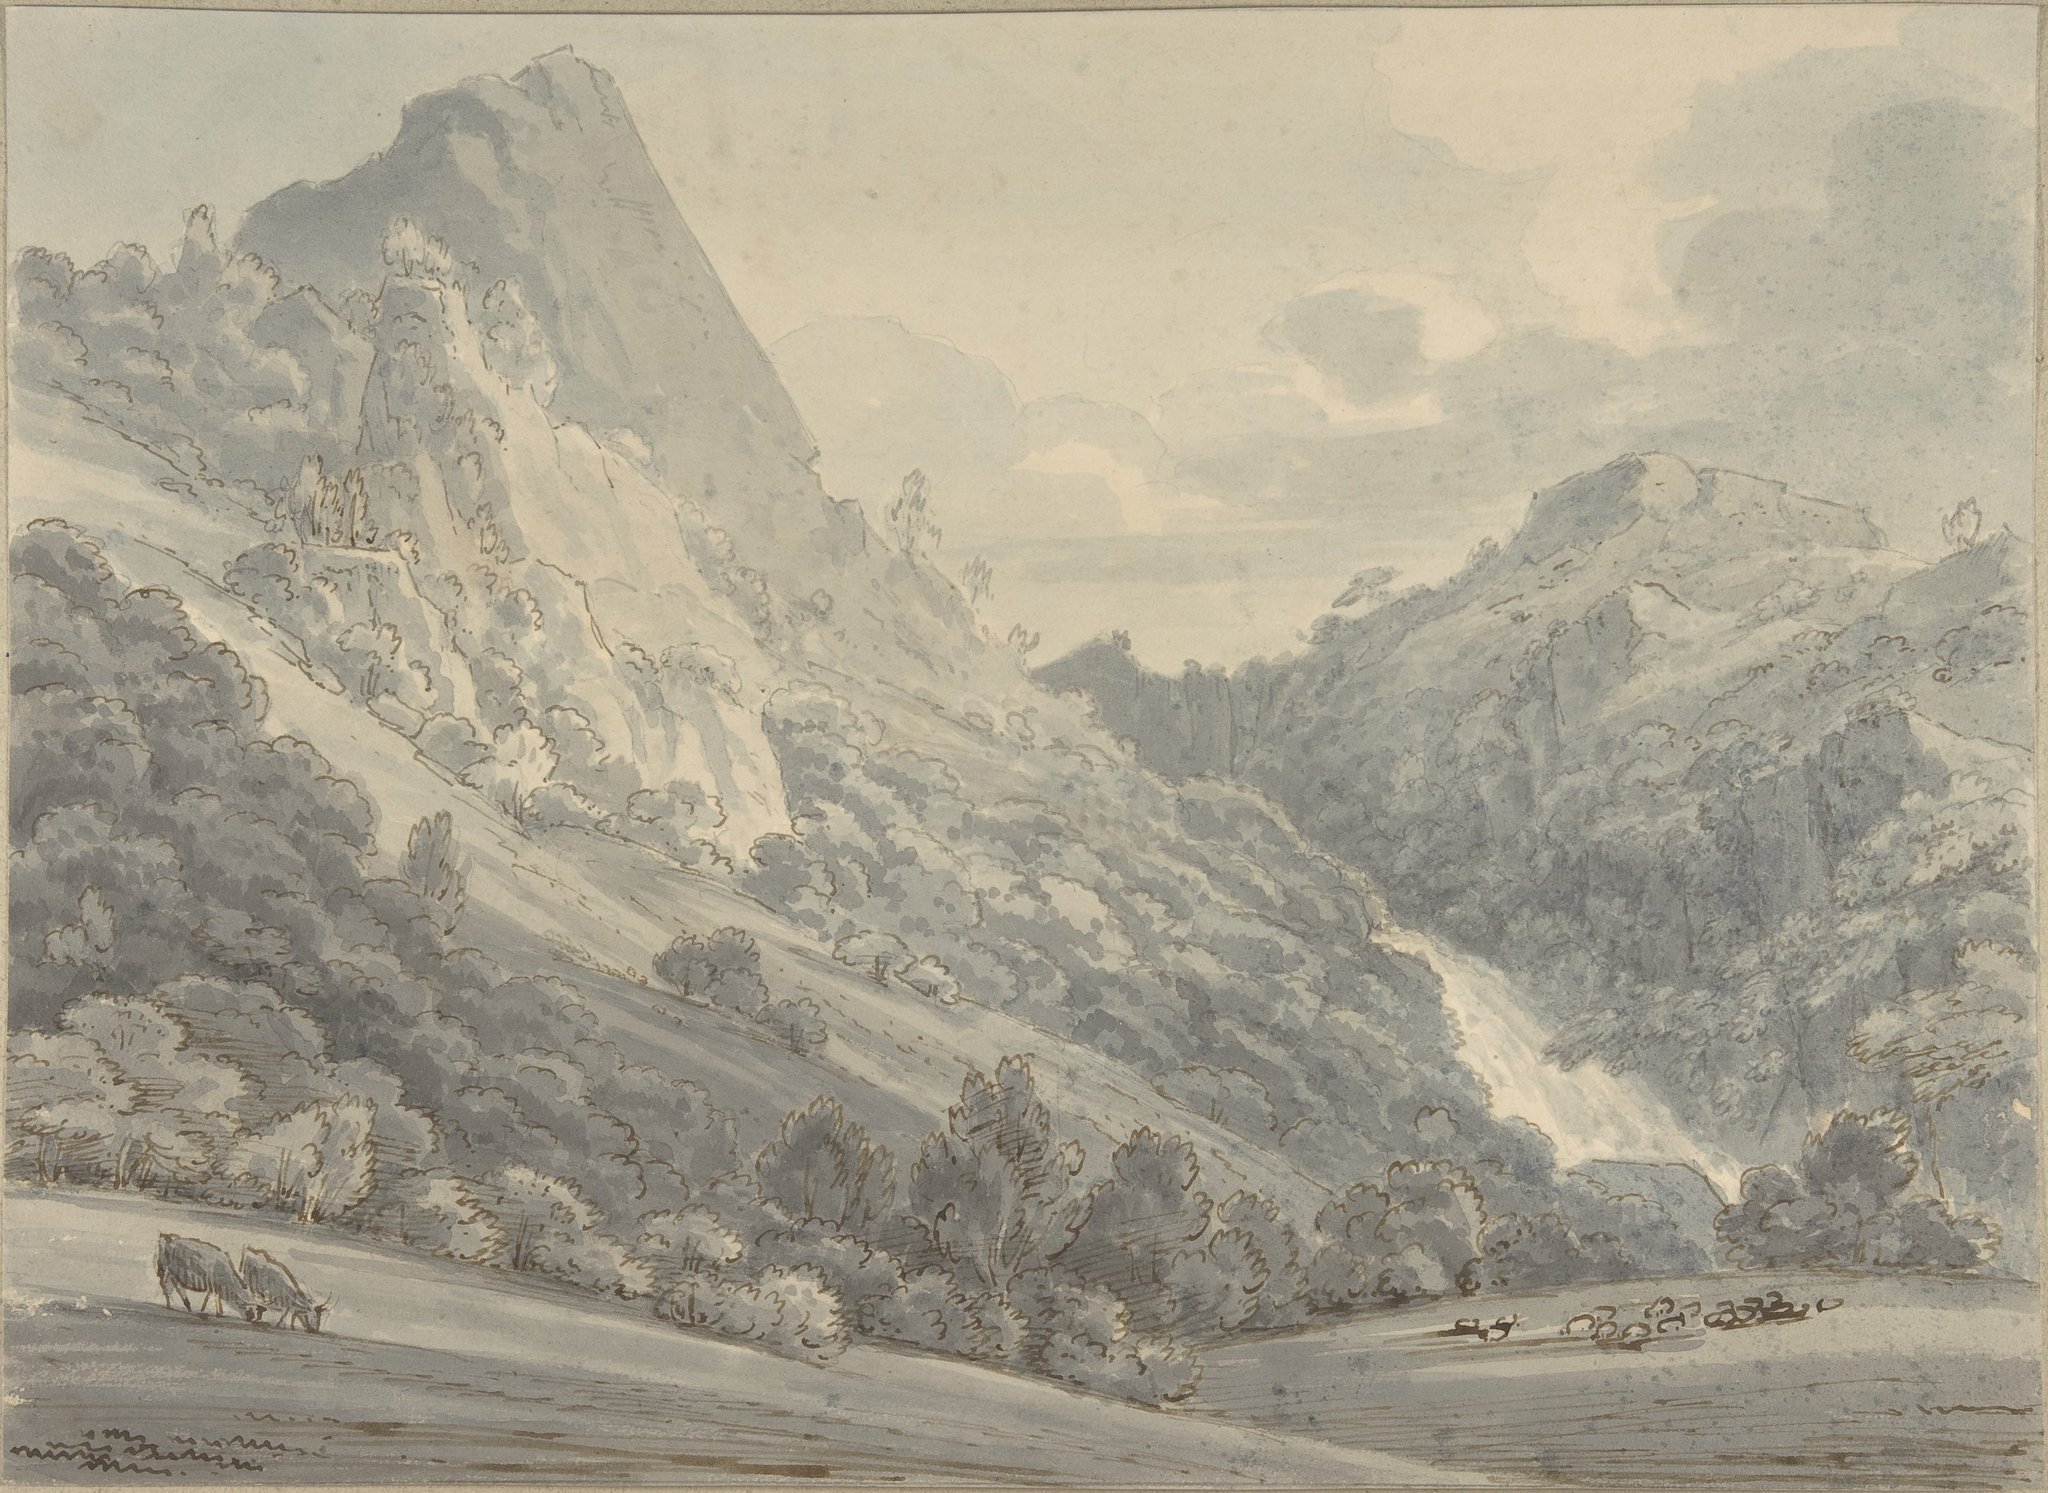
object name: drawing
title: The Falls of Lodore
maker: thomas sunderland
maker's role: artist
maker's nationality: british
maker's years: 1744-1828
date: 1764-1828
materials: ink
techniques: brush, pen, wash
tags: animals,waterfalls,mountains,landscapes,trees